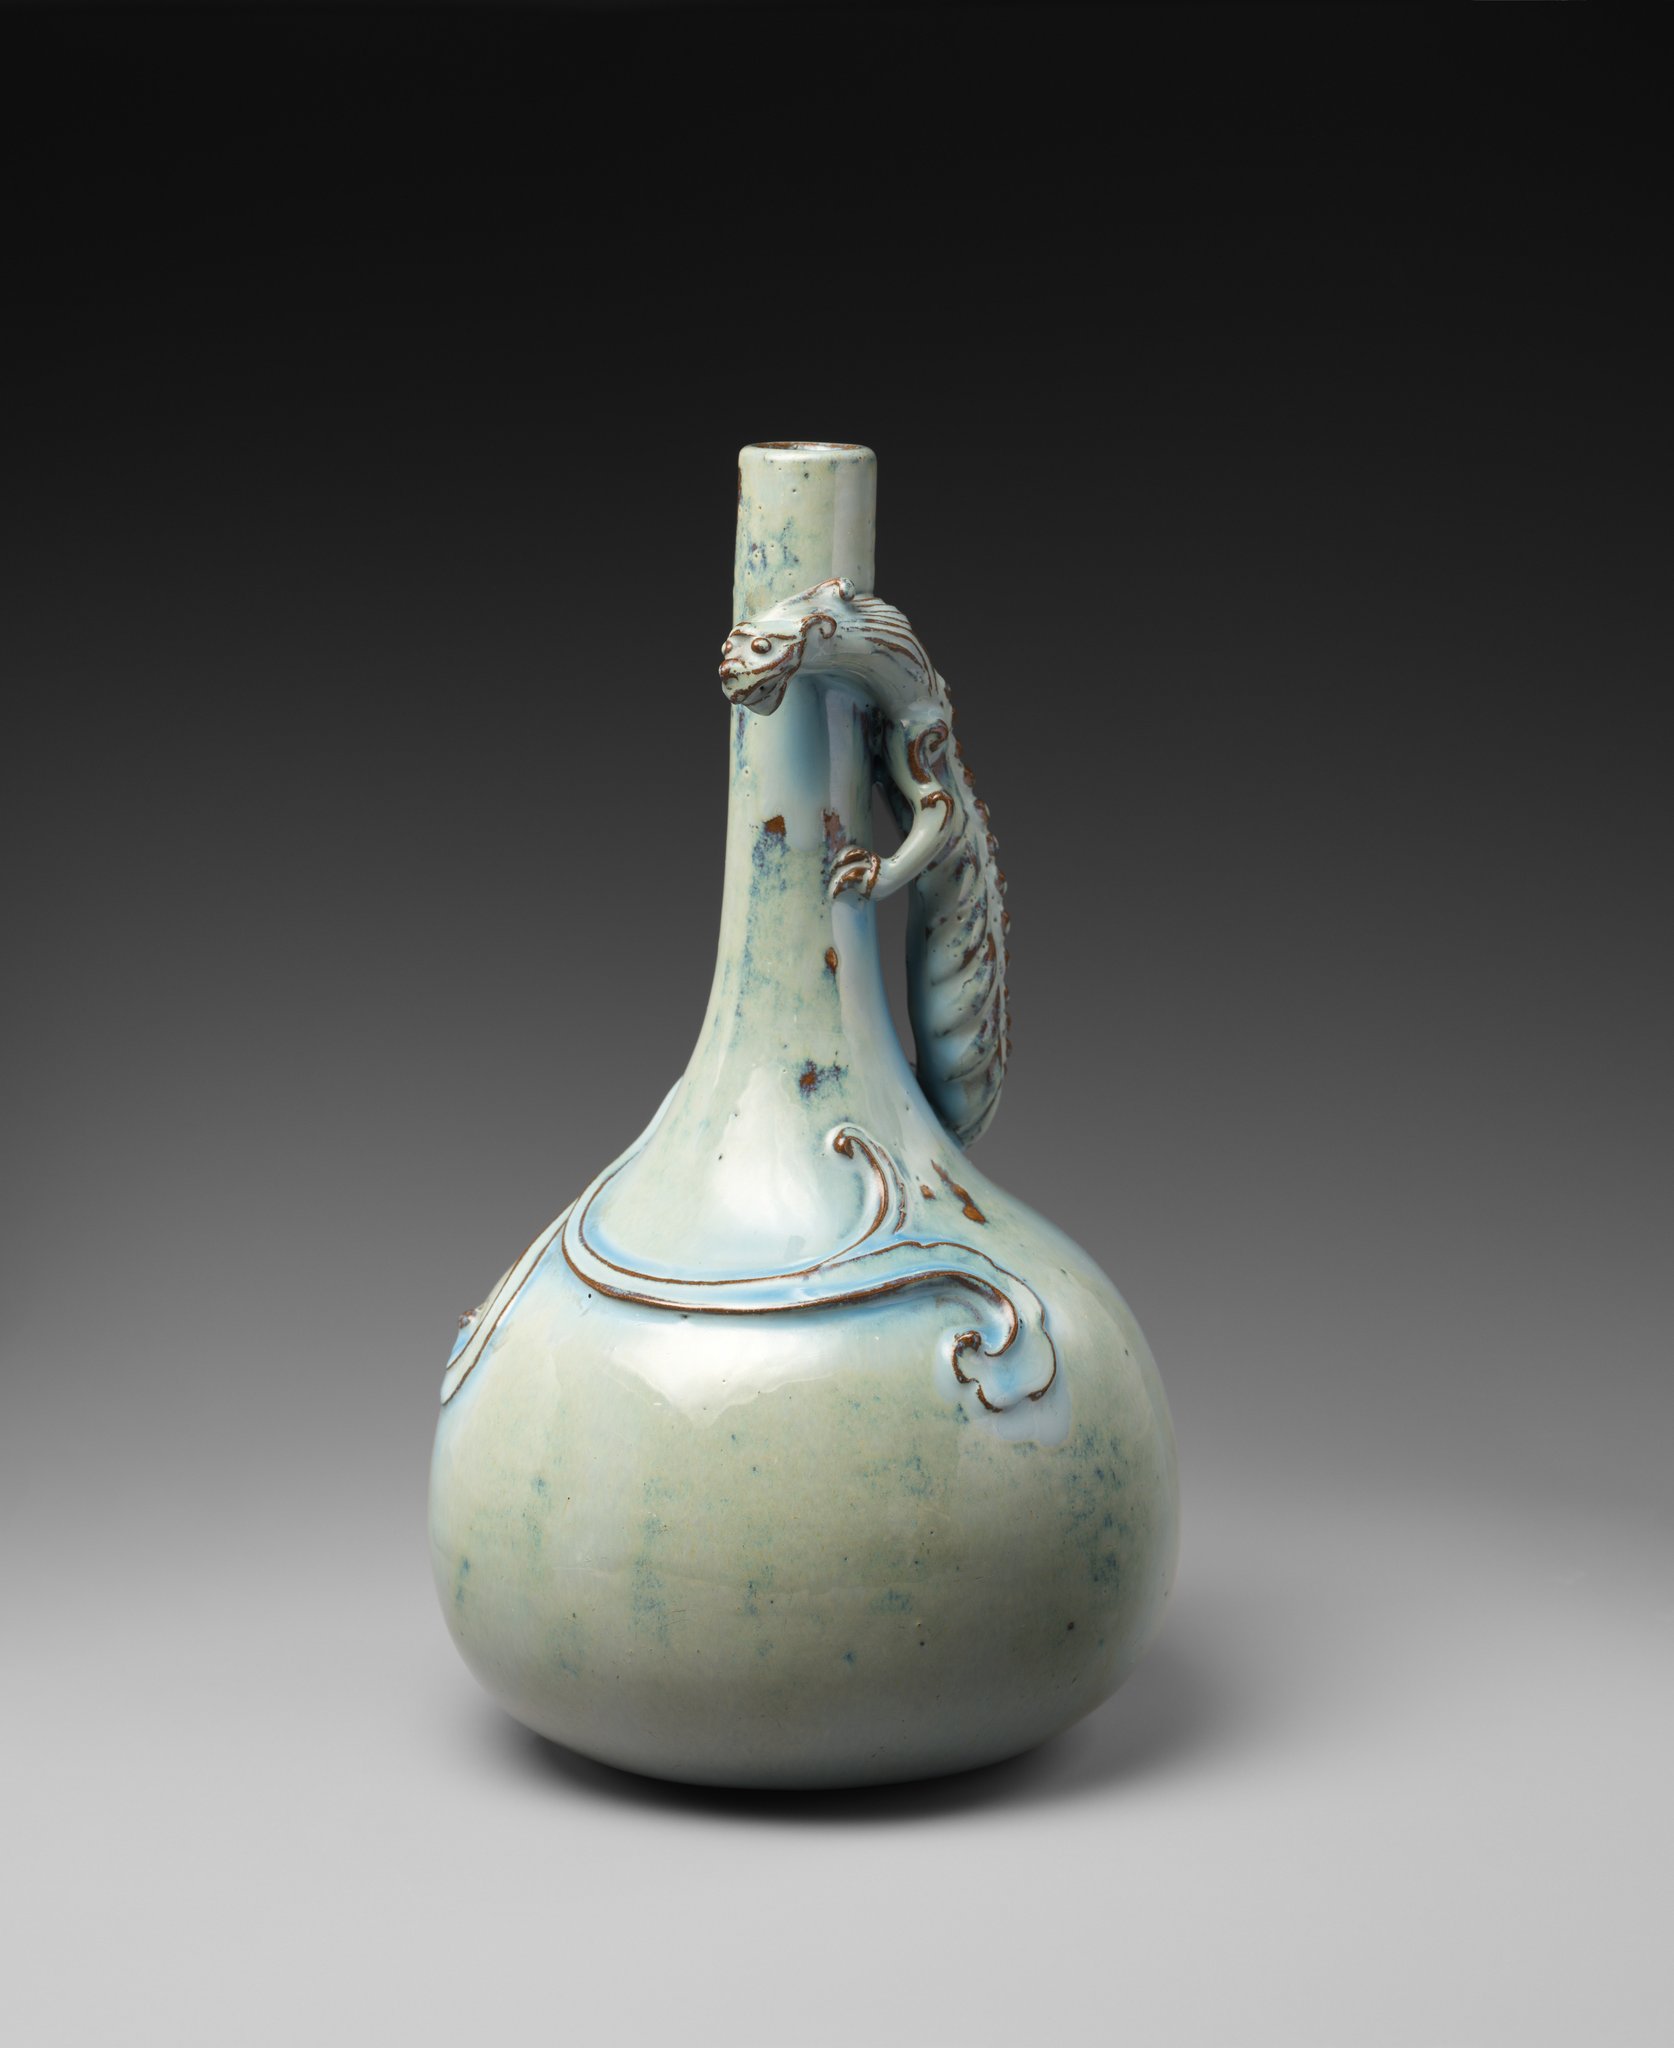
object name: vase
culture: chinese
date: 1644-1911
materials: stoneware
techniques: glazing